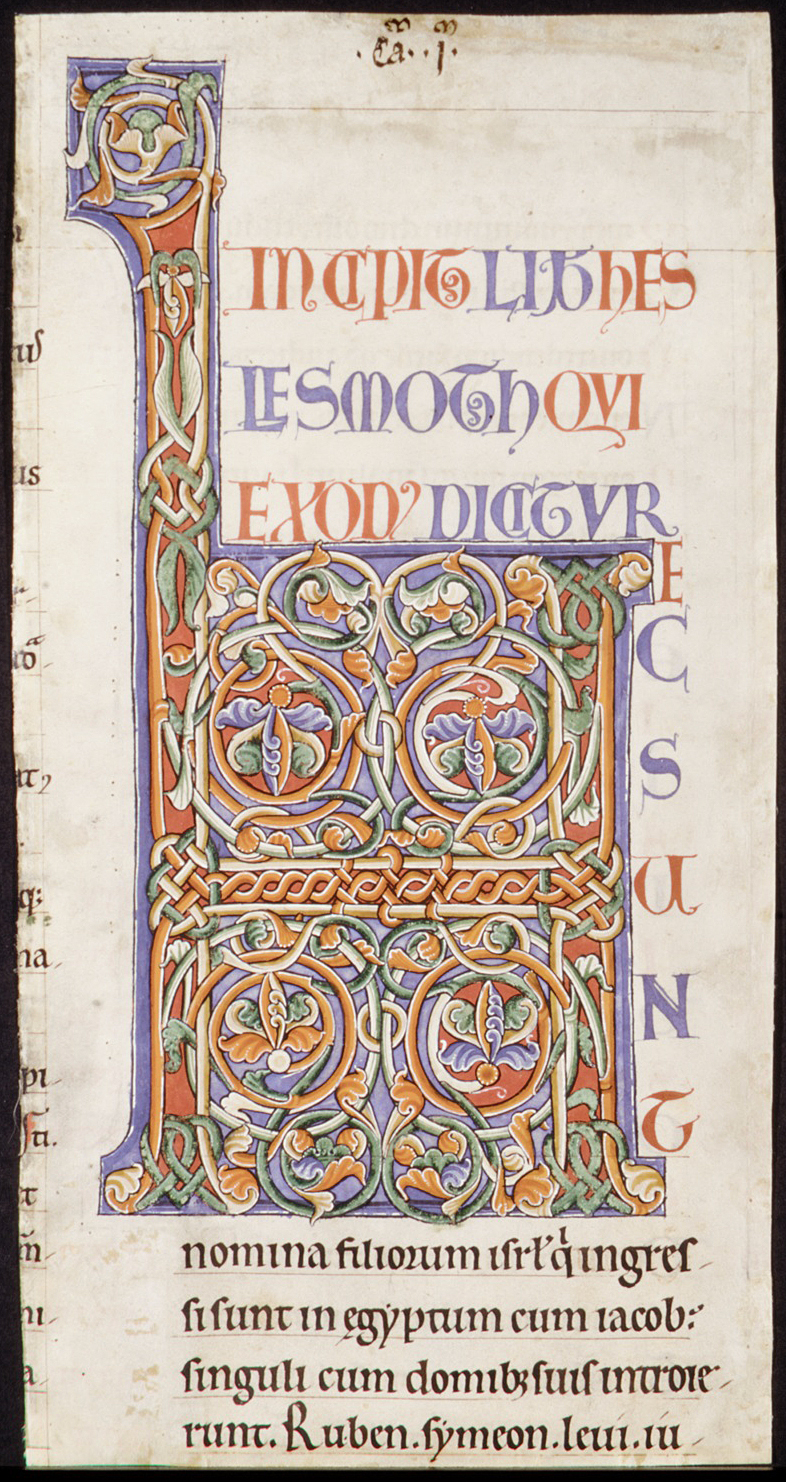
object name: bible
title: Manuscript Illumination with Initial H, from a Bible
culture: french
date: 1175-1195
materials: gold, parchment, paint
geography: france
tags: bible